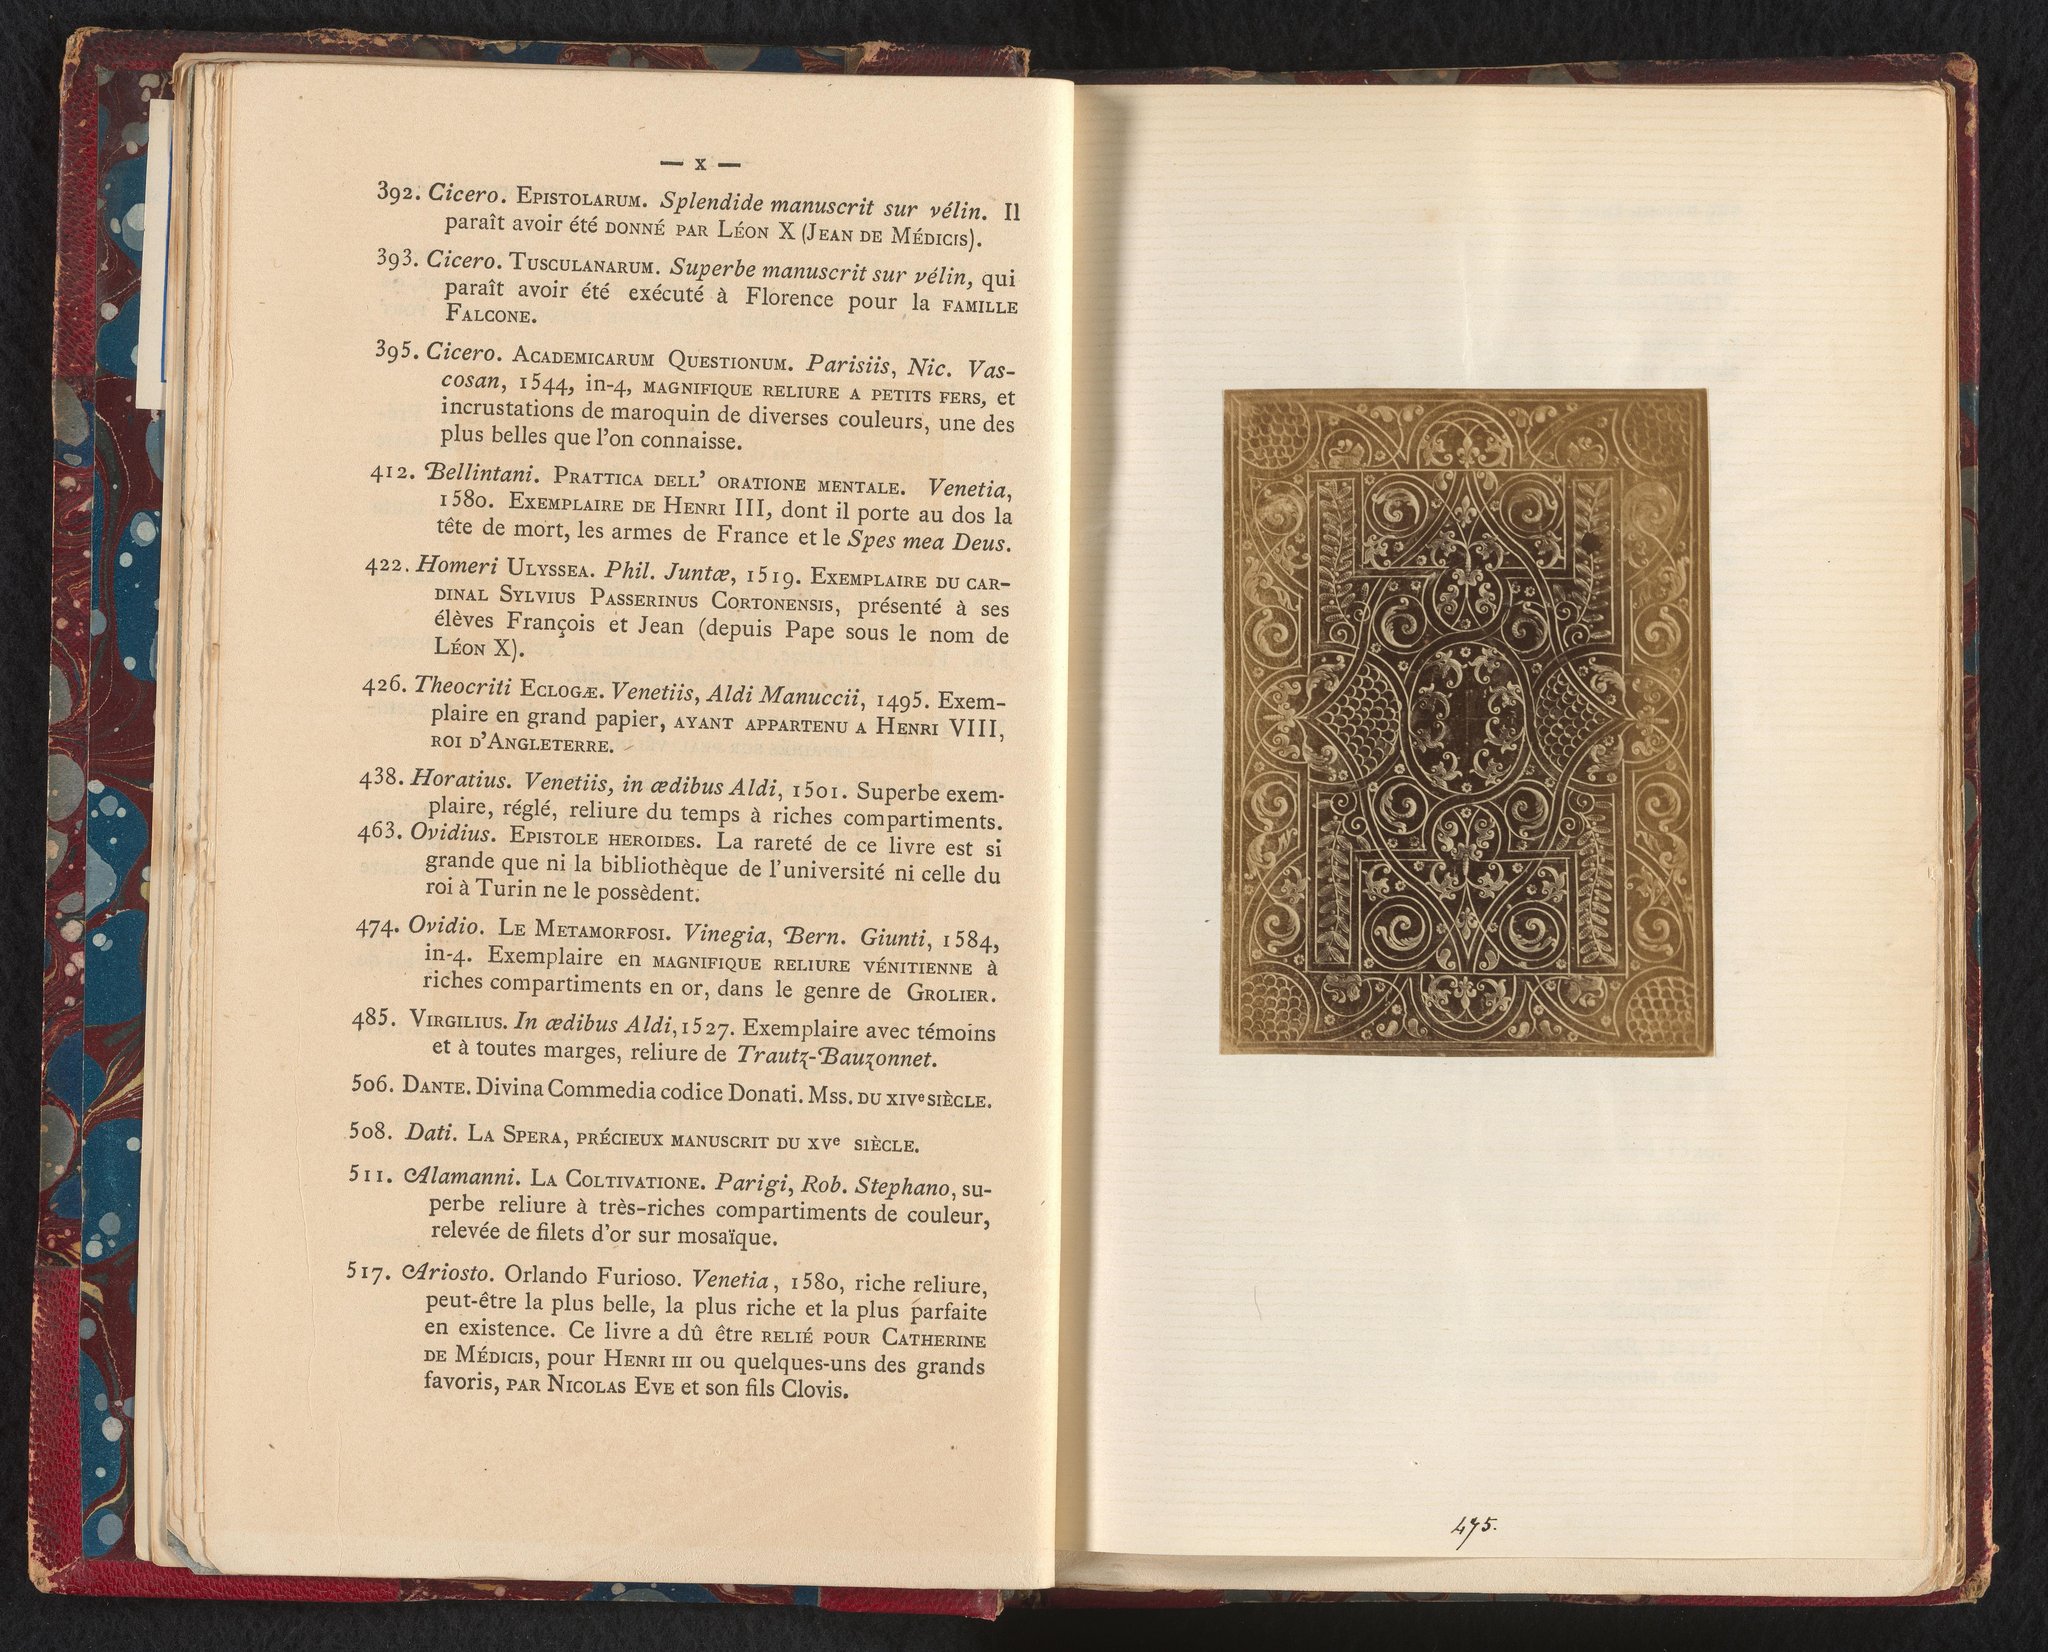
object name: photograph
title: Fotoreproductie van boekomslag van Ovidius' La Vita e Metamorfoseo uit 1584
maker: Anonymous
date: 1863-1868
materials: paper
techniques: albumen print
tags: book-cover, binding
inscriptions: number: ‘475’